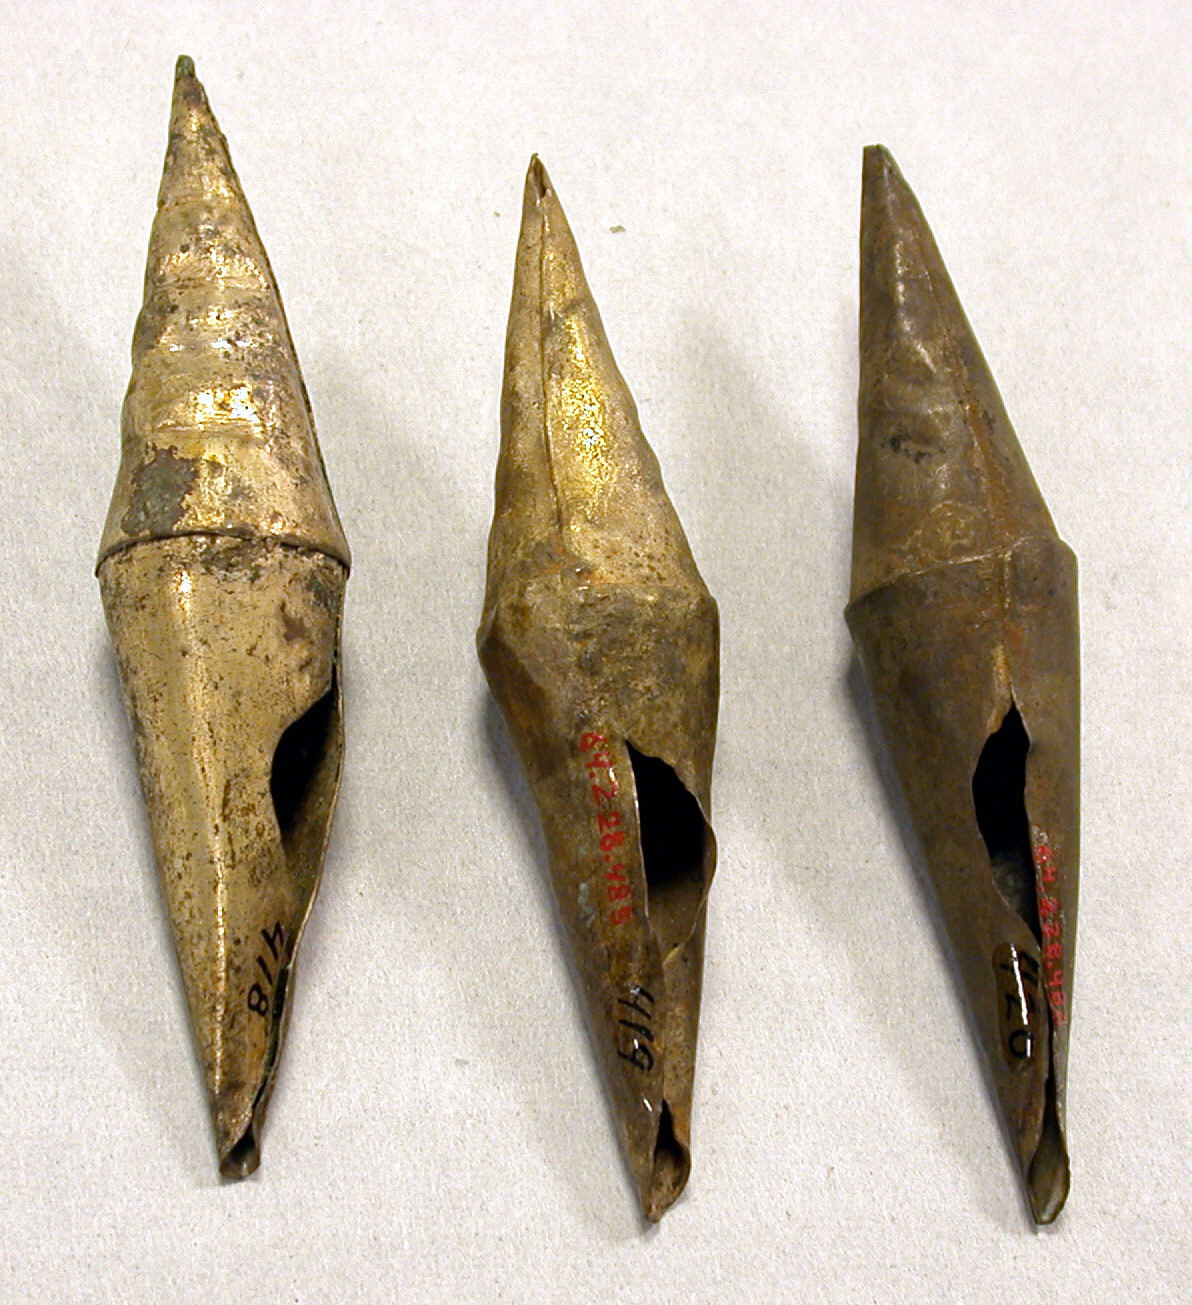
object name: ornament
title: Hammered Silver Cone Ornament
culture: peruvian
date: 701-1566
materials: gilt, silver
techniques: hammering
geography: peru